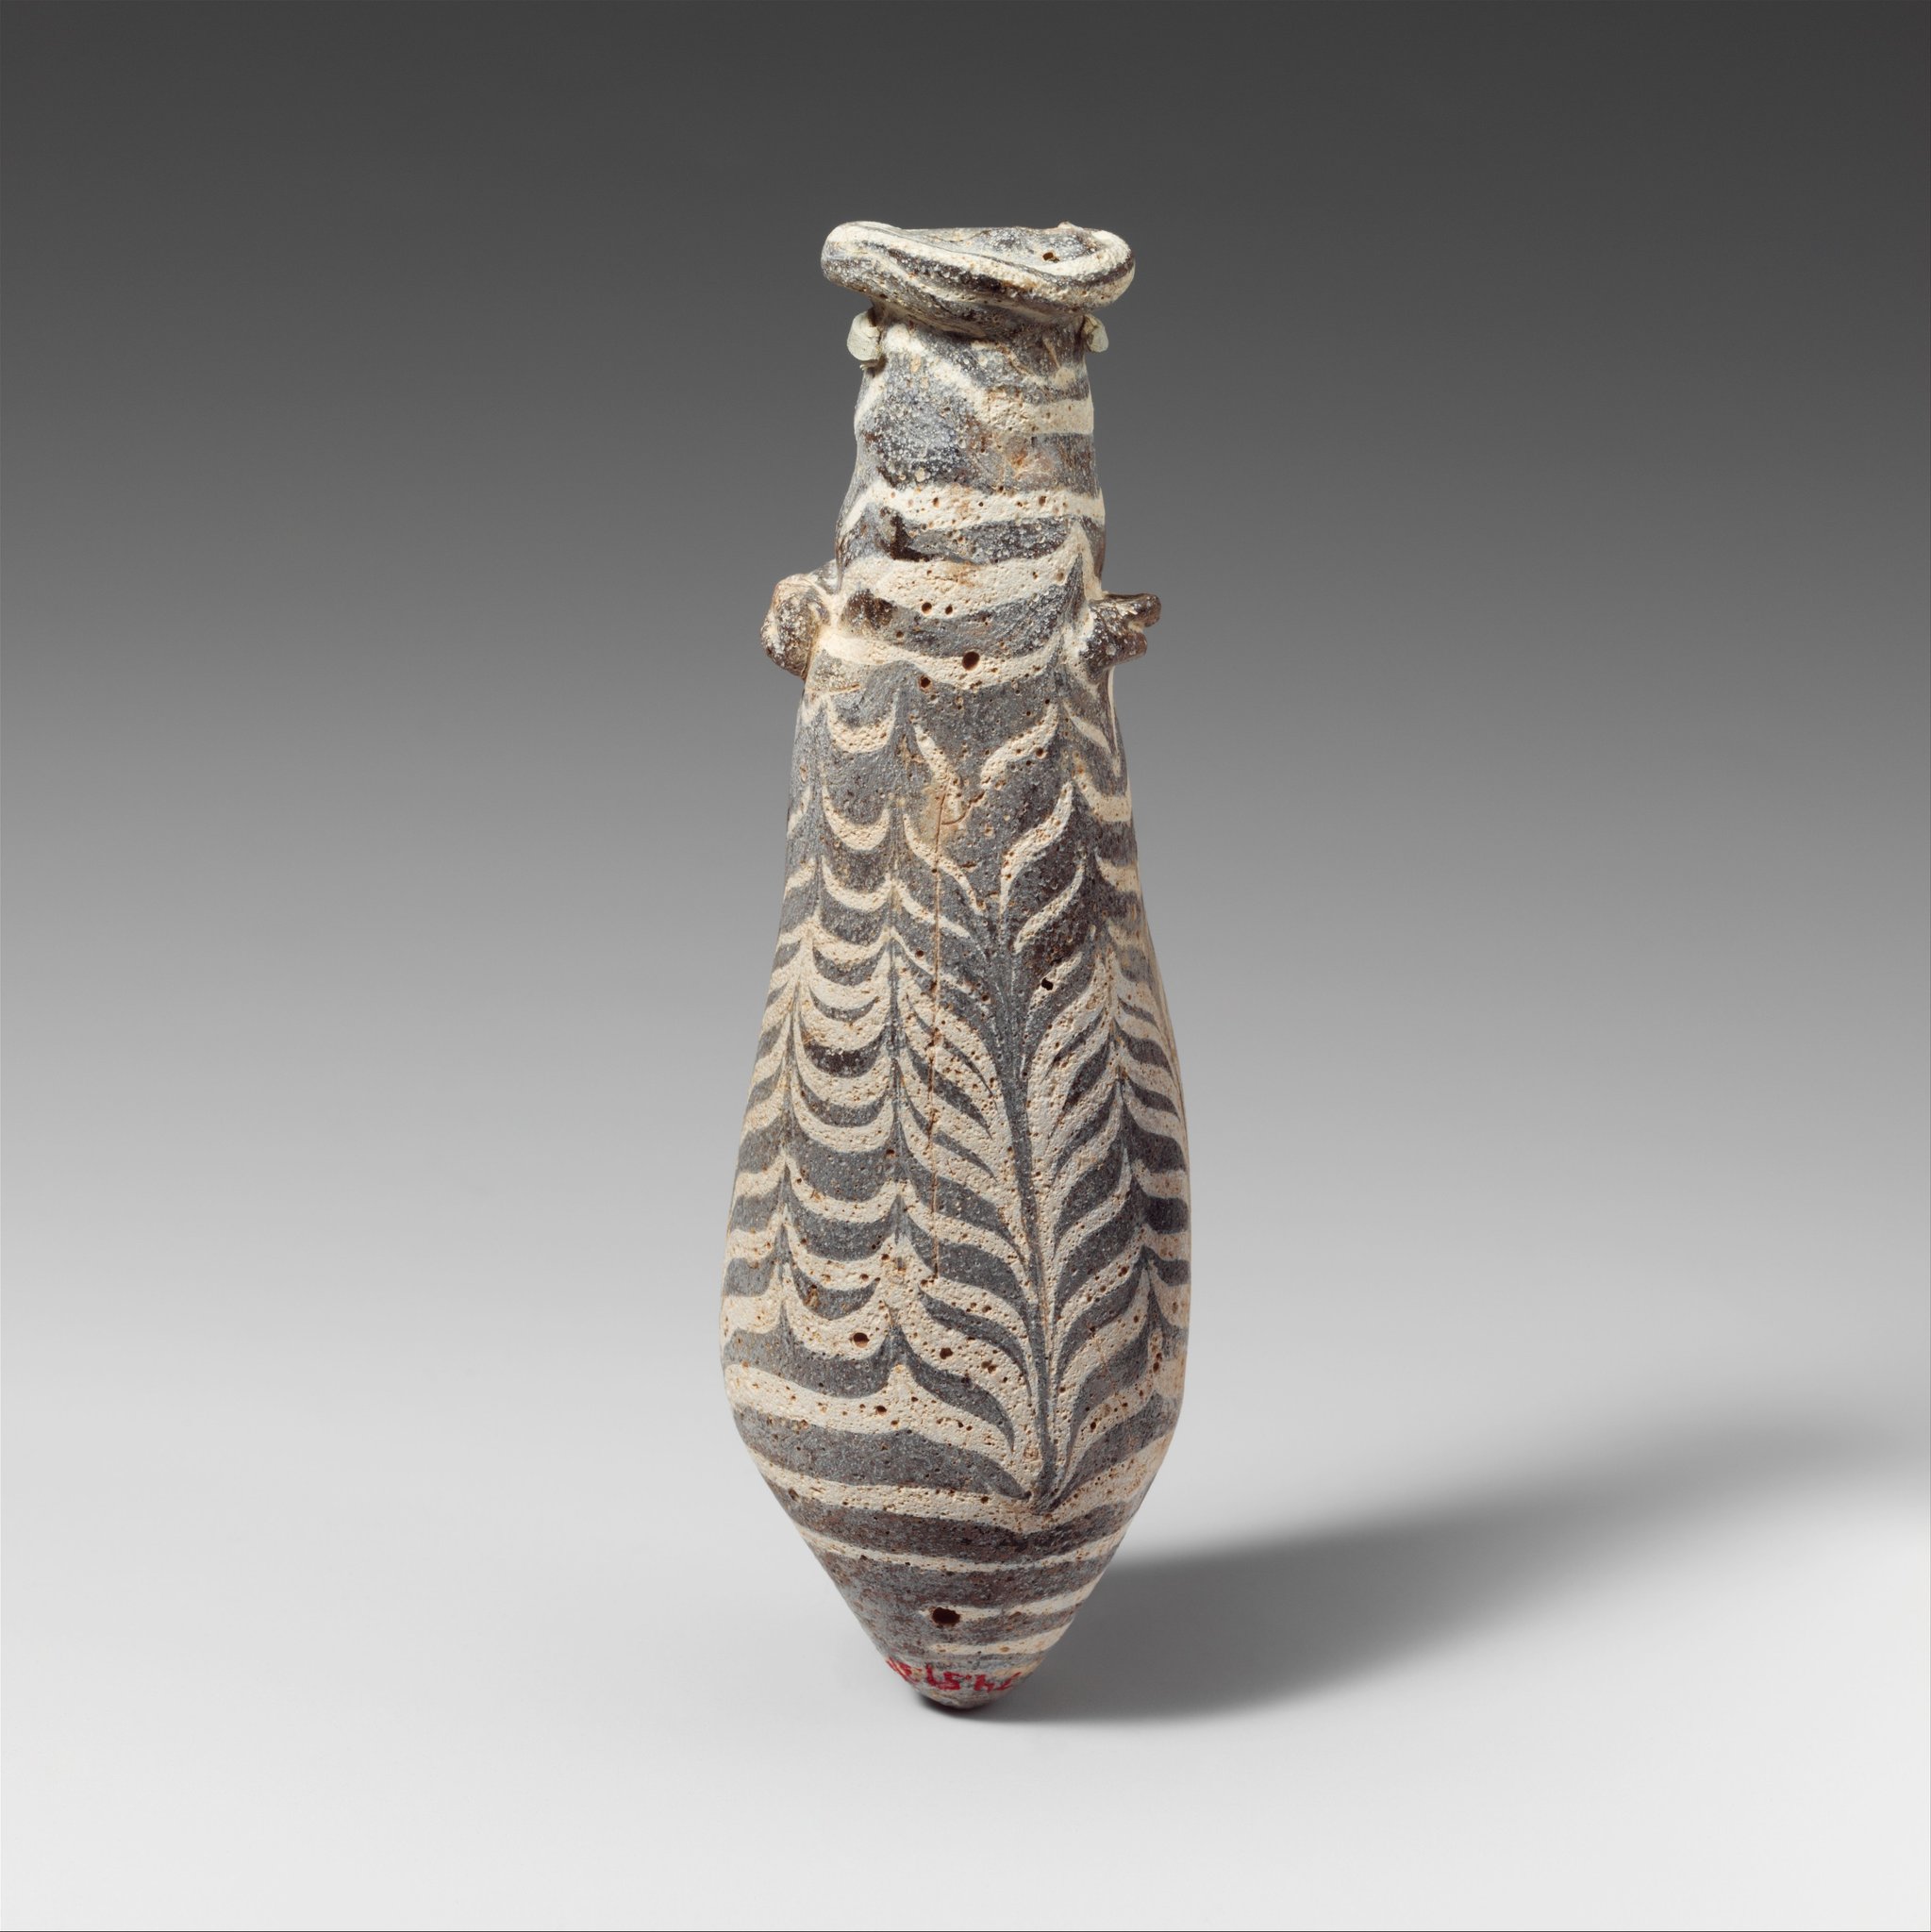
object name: alabastron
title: Glass alabastron (perfume bottle)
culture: greek, eastern mediterranean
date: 200-1 BCE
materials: glass